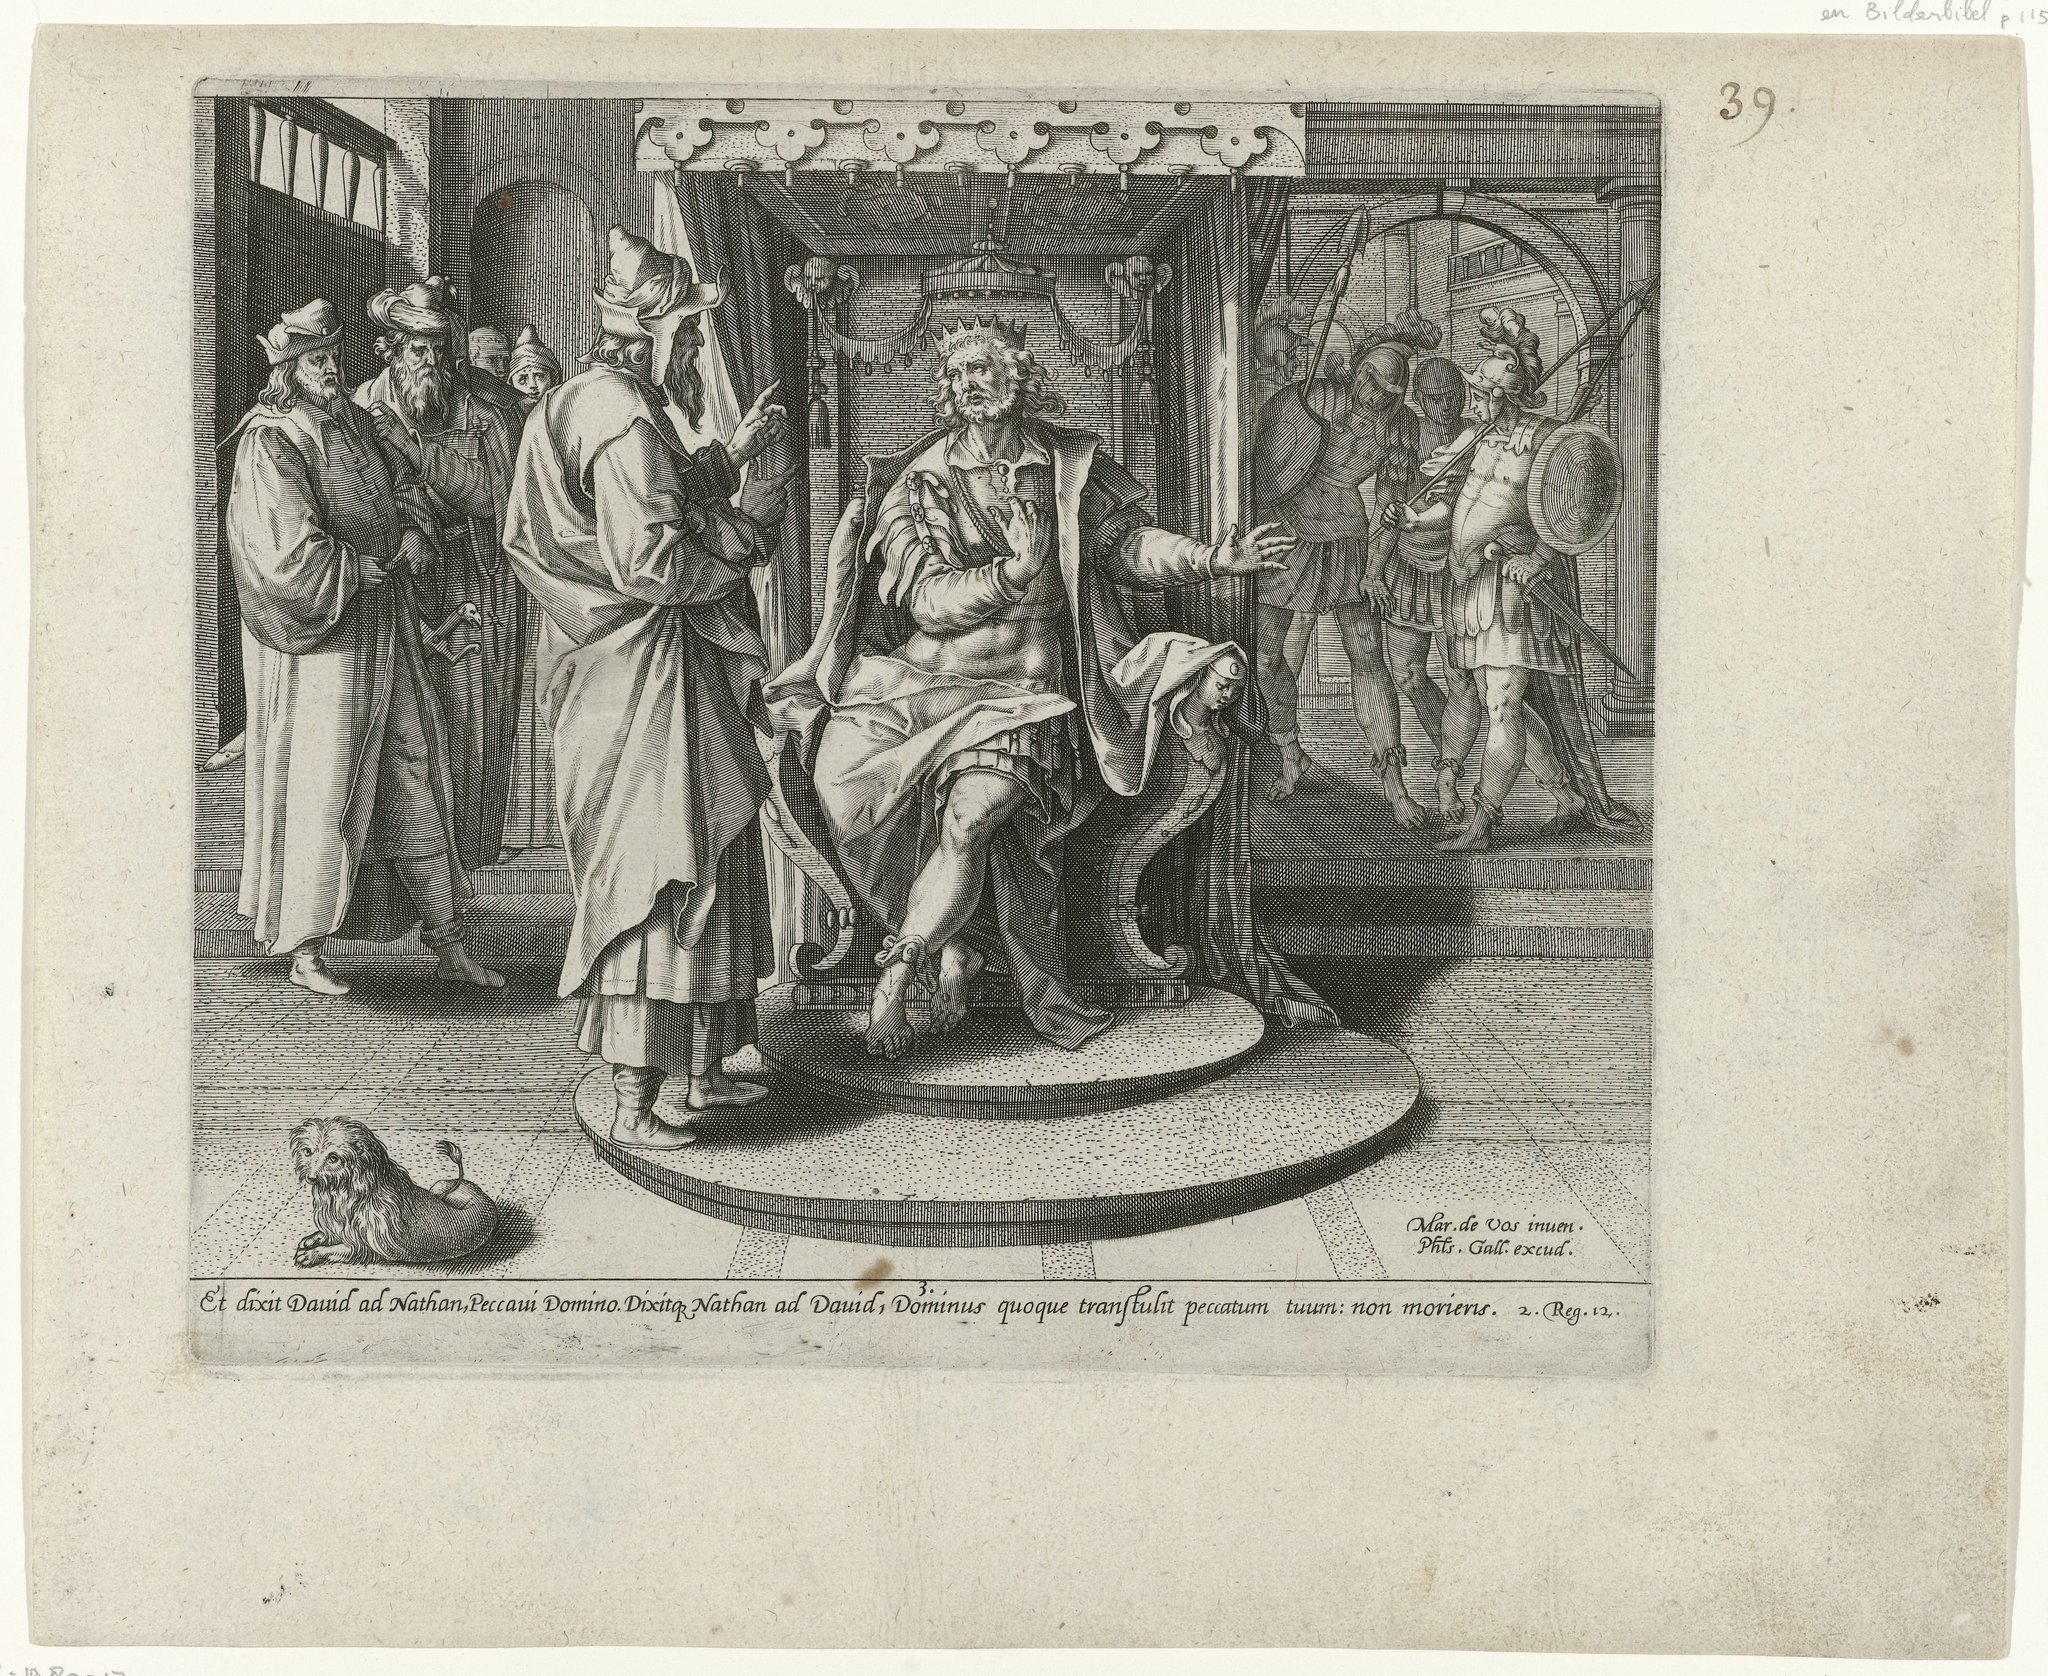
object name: print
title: Boetedoening en berouw in het Oude Testament en het Nieuwe Testament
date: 1547-1612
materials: paper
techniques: engraving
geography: antwerp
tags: david rebuked by nathan, in his palace of cedar, david speaks with nathan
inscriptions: collector's mark: Lugt 2760, number: ‘39’, collector's mark: Lugt 2228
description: Omwille van het overspel met Batseba wordt koning David door de profeet Natan berispt in naam van God. Koning David biecht zijn zonde op. De prent heeft een Latijns onderschrift en is deel van een serie over boetedoening en berouw in het Oude en Nieuwe Testament.